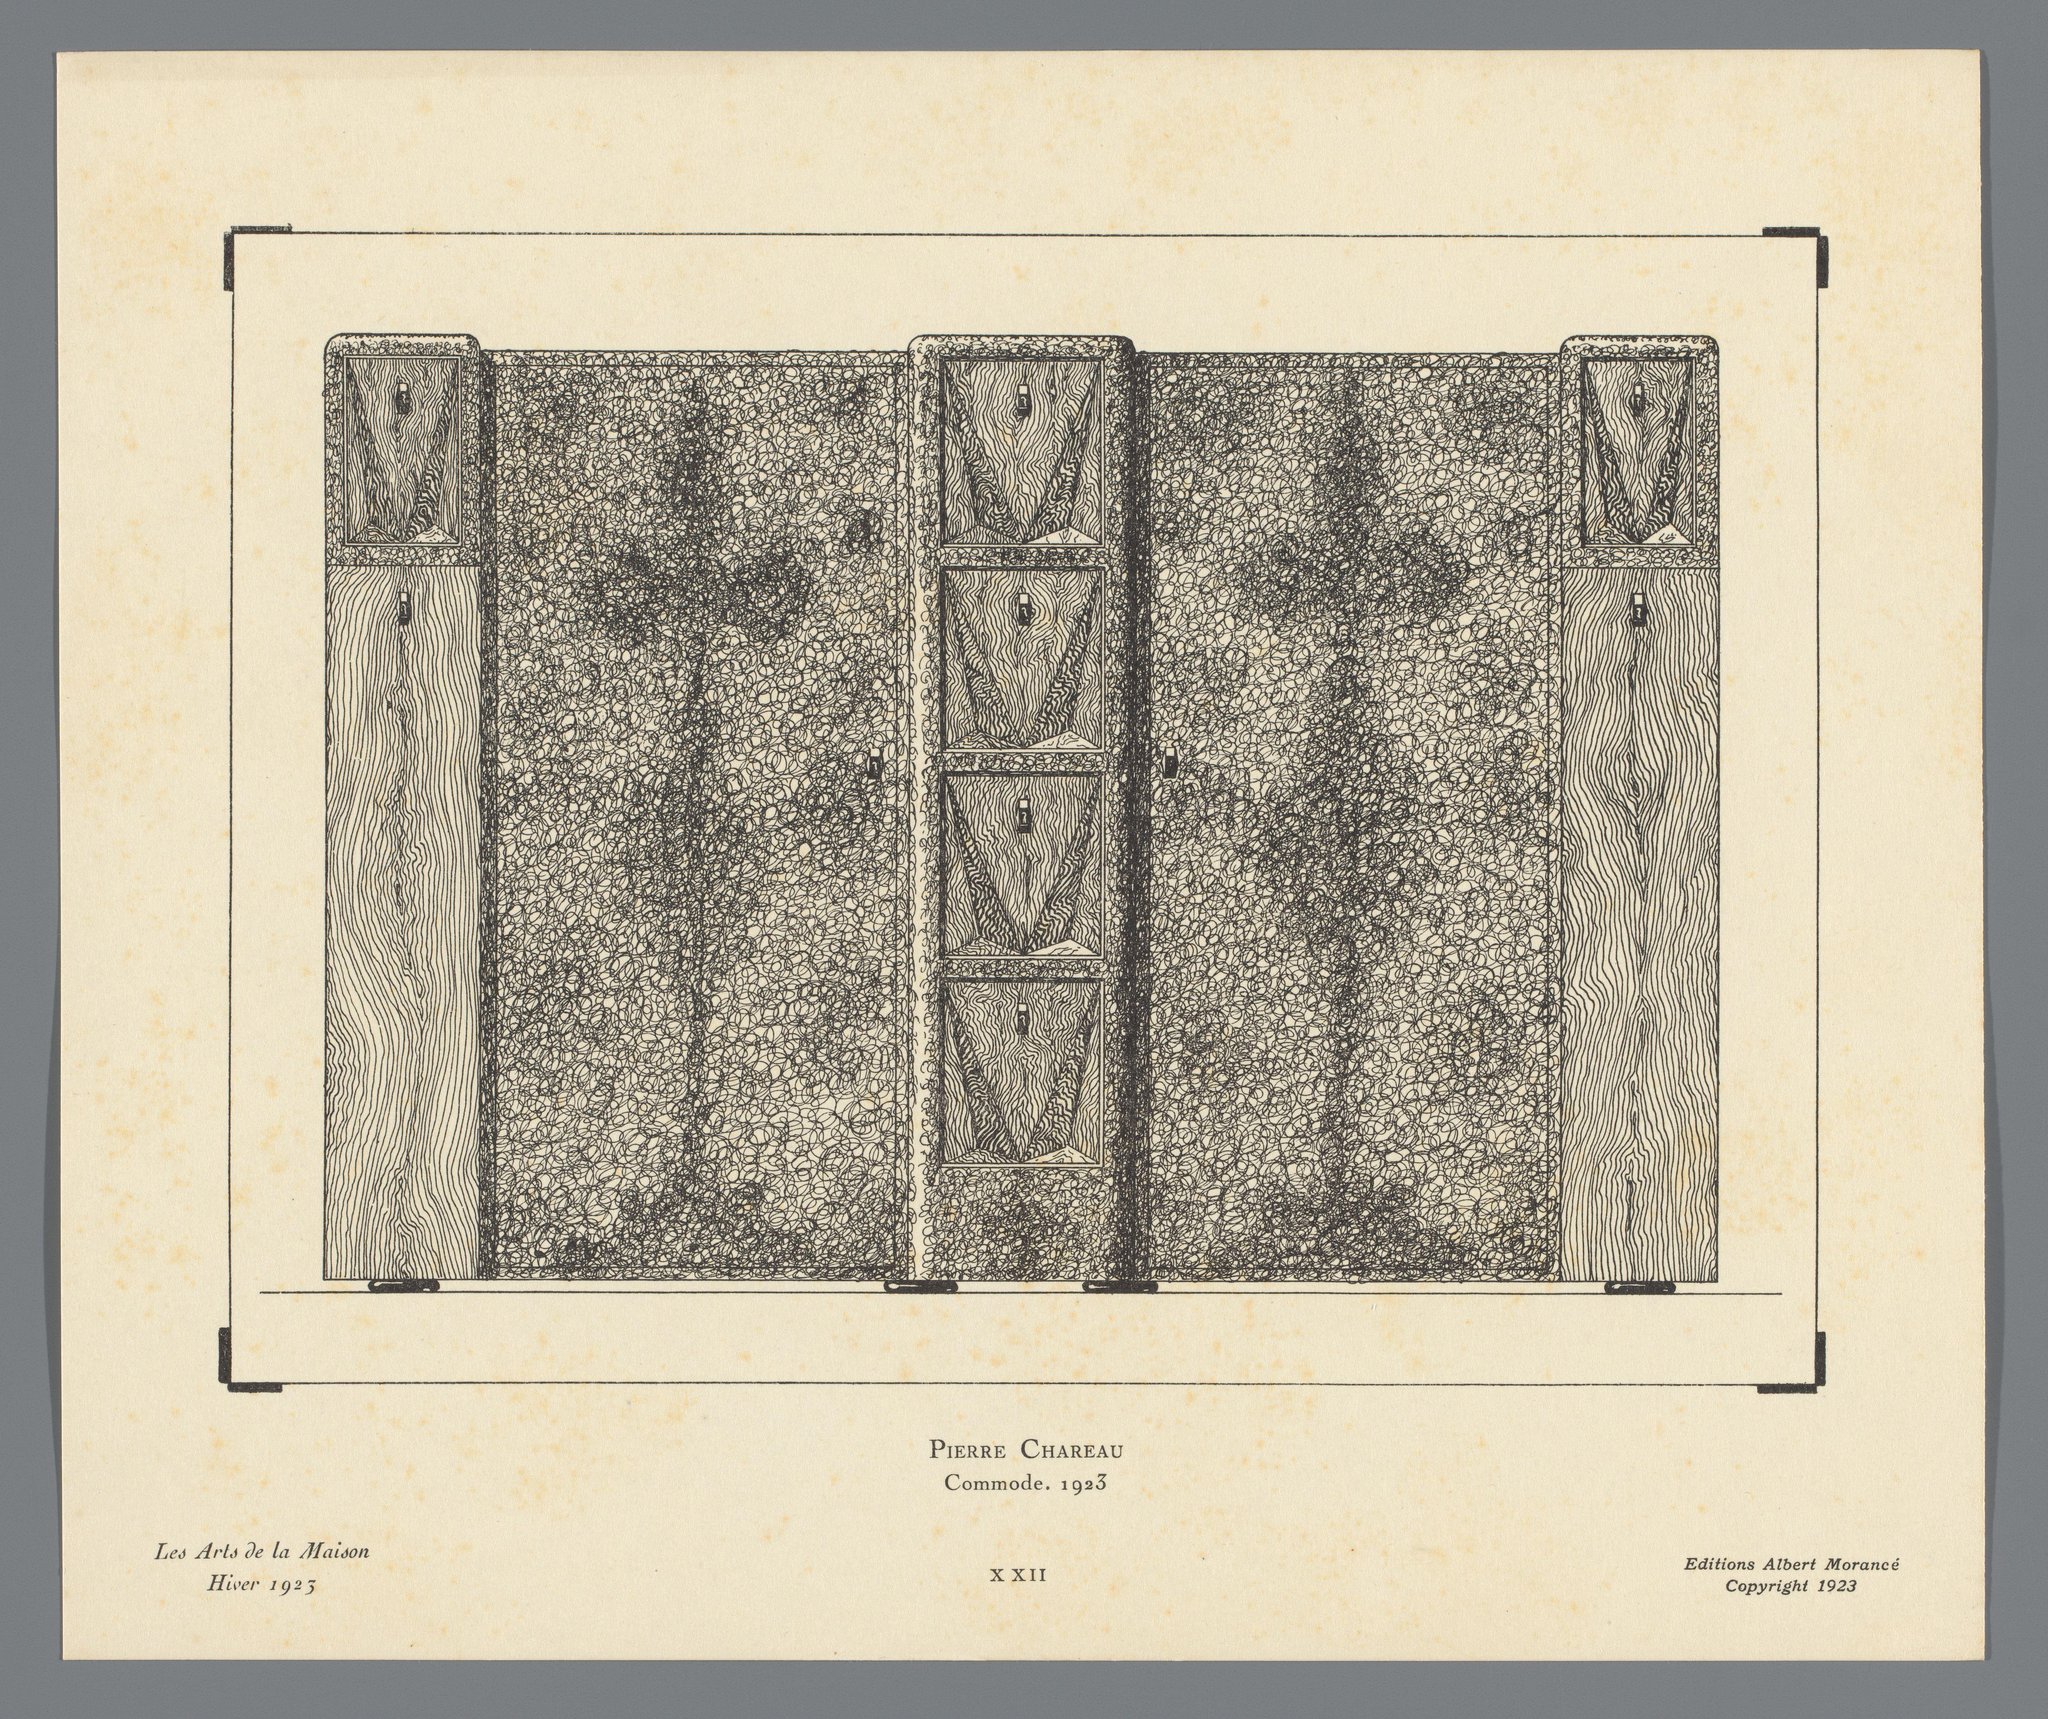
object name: photograph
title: Pierre Chareau. Commode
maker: Anonymous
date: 1923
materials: paper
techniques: lithograph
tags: france